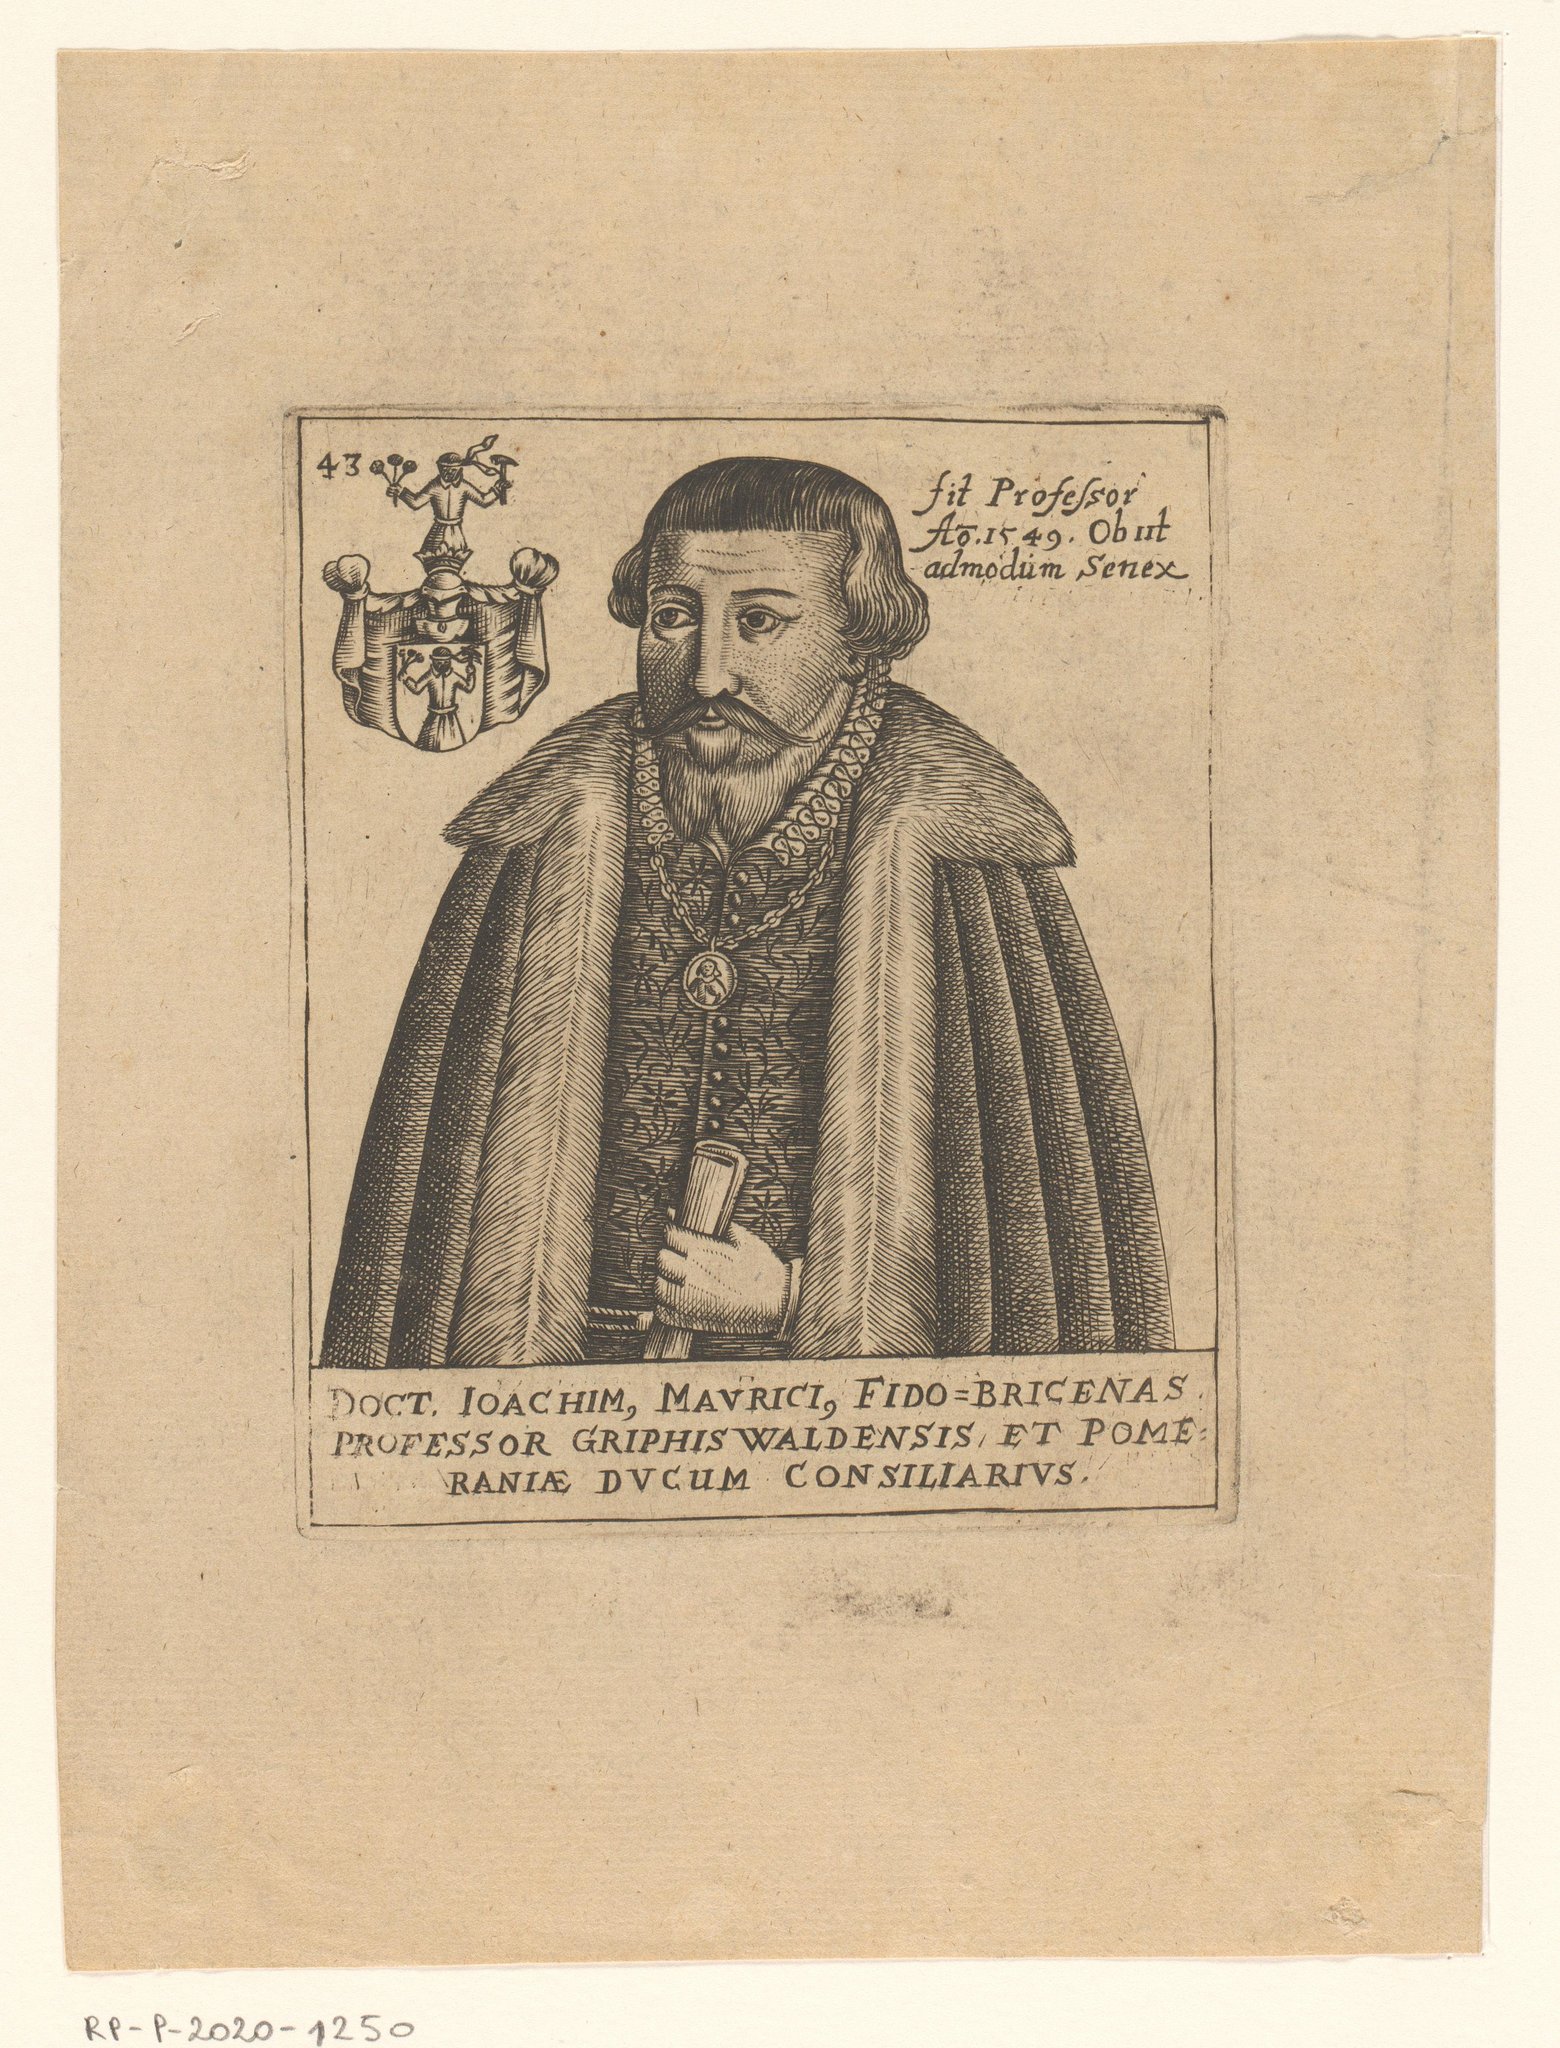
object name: print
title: Portret van Joachim Mauritius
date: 1671-1751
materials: paper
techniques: engraving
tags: historical persons, professor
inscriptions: collector's mark: Lugt 2228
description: De prent is uitgegeven als onderdeel van een serie. Later is de prent mogelijk ook als boekillustratie gebruikt in: Küster, Georg Gottfried. Martin Friedrich Seidels Bilder-Sammlung in welcher hundert, gröstentheils in der Mark Brandenburg (…). Berlijn: Buchladen bey der Real-Schule, 1751. Het is onduidelijk tot welke uitgave de huidige prent behoort.